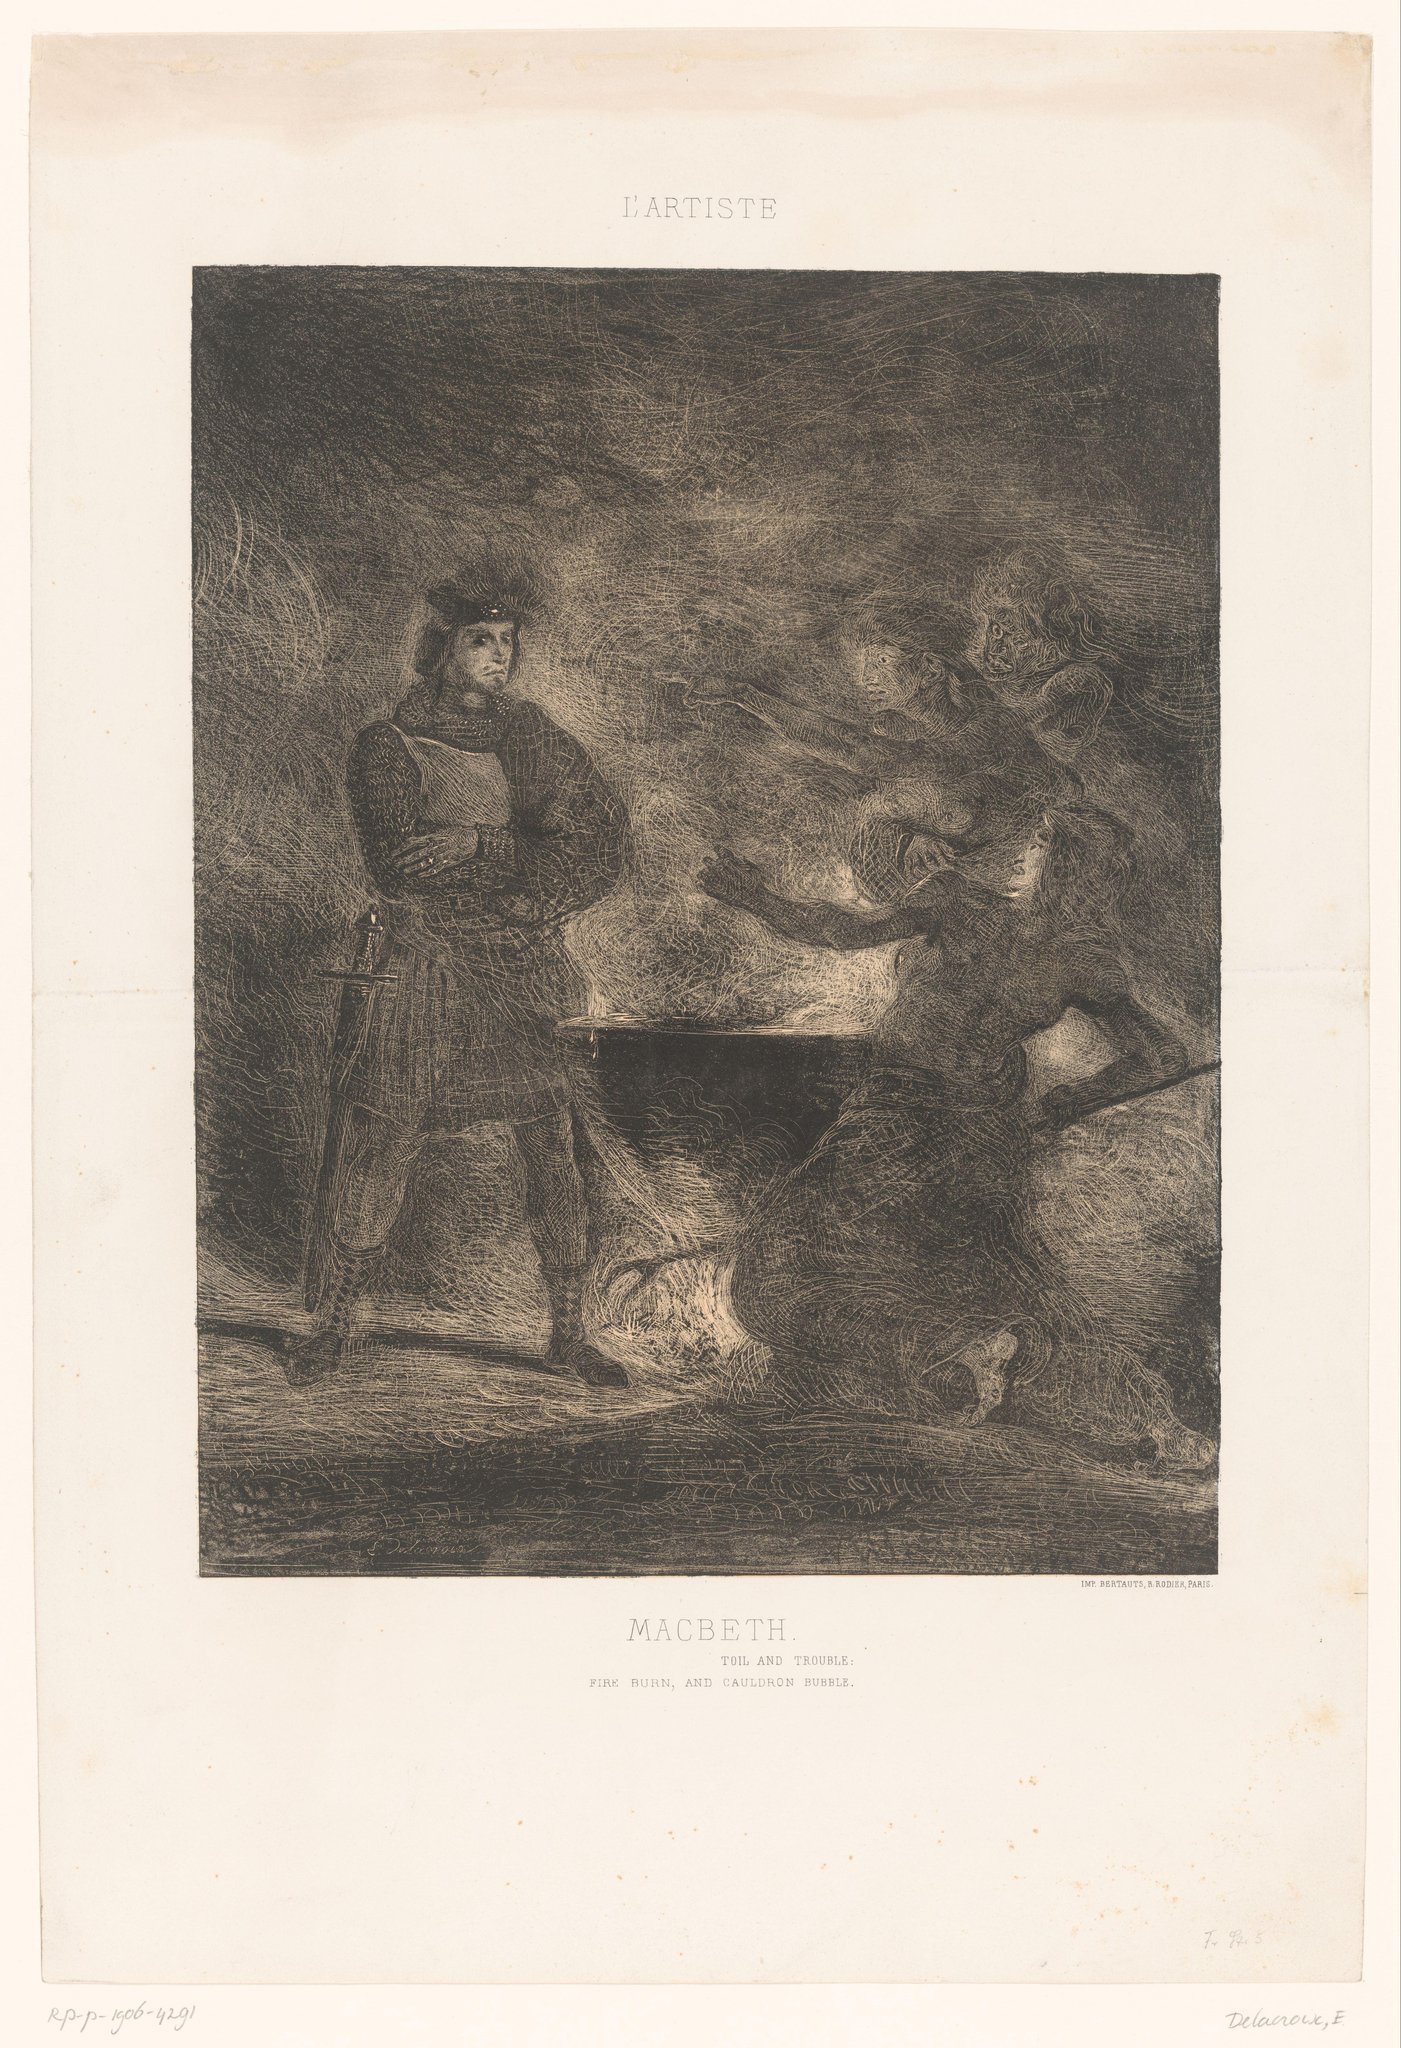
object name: print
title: Macbeth raadpleegt de drie heksen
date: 1825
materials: paper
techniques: etching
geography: paris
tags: macbeth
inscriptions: collector's mark: Lugt 2228a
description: Prent gebruikt voor: L'Artiste, journal de la littérature et des beaux-arts, 1 mei 1864.